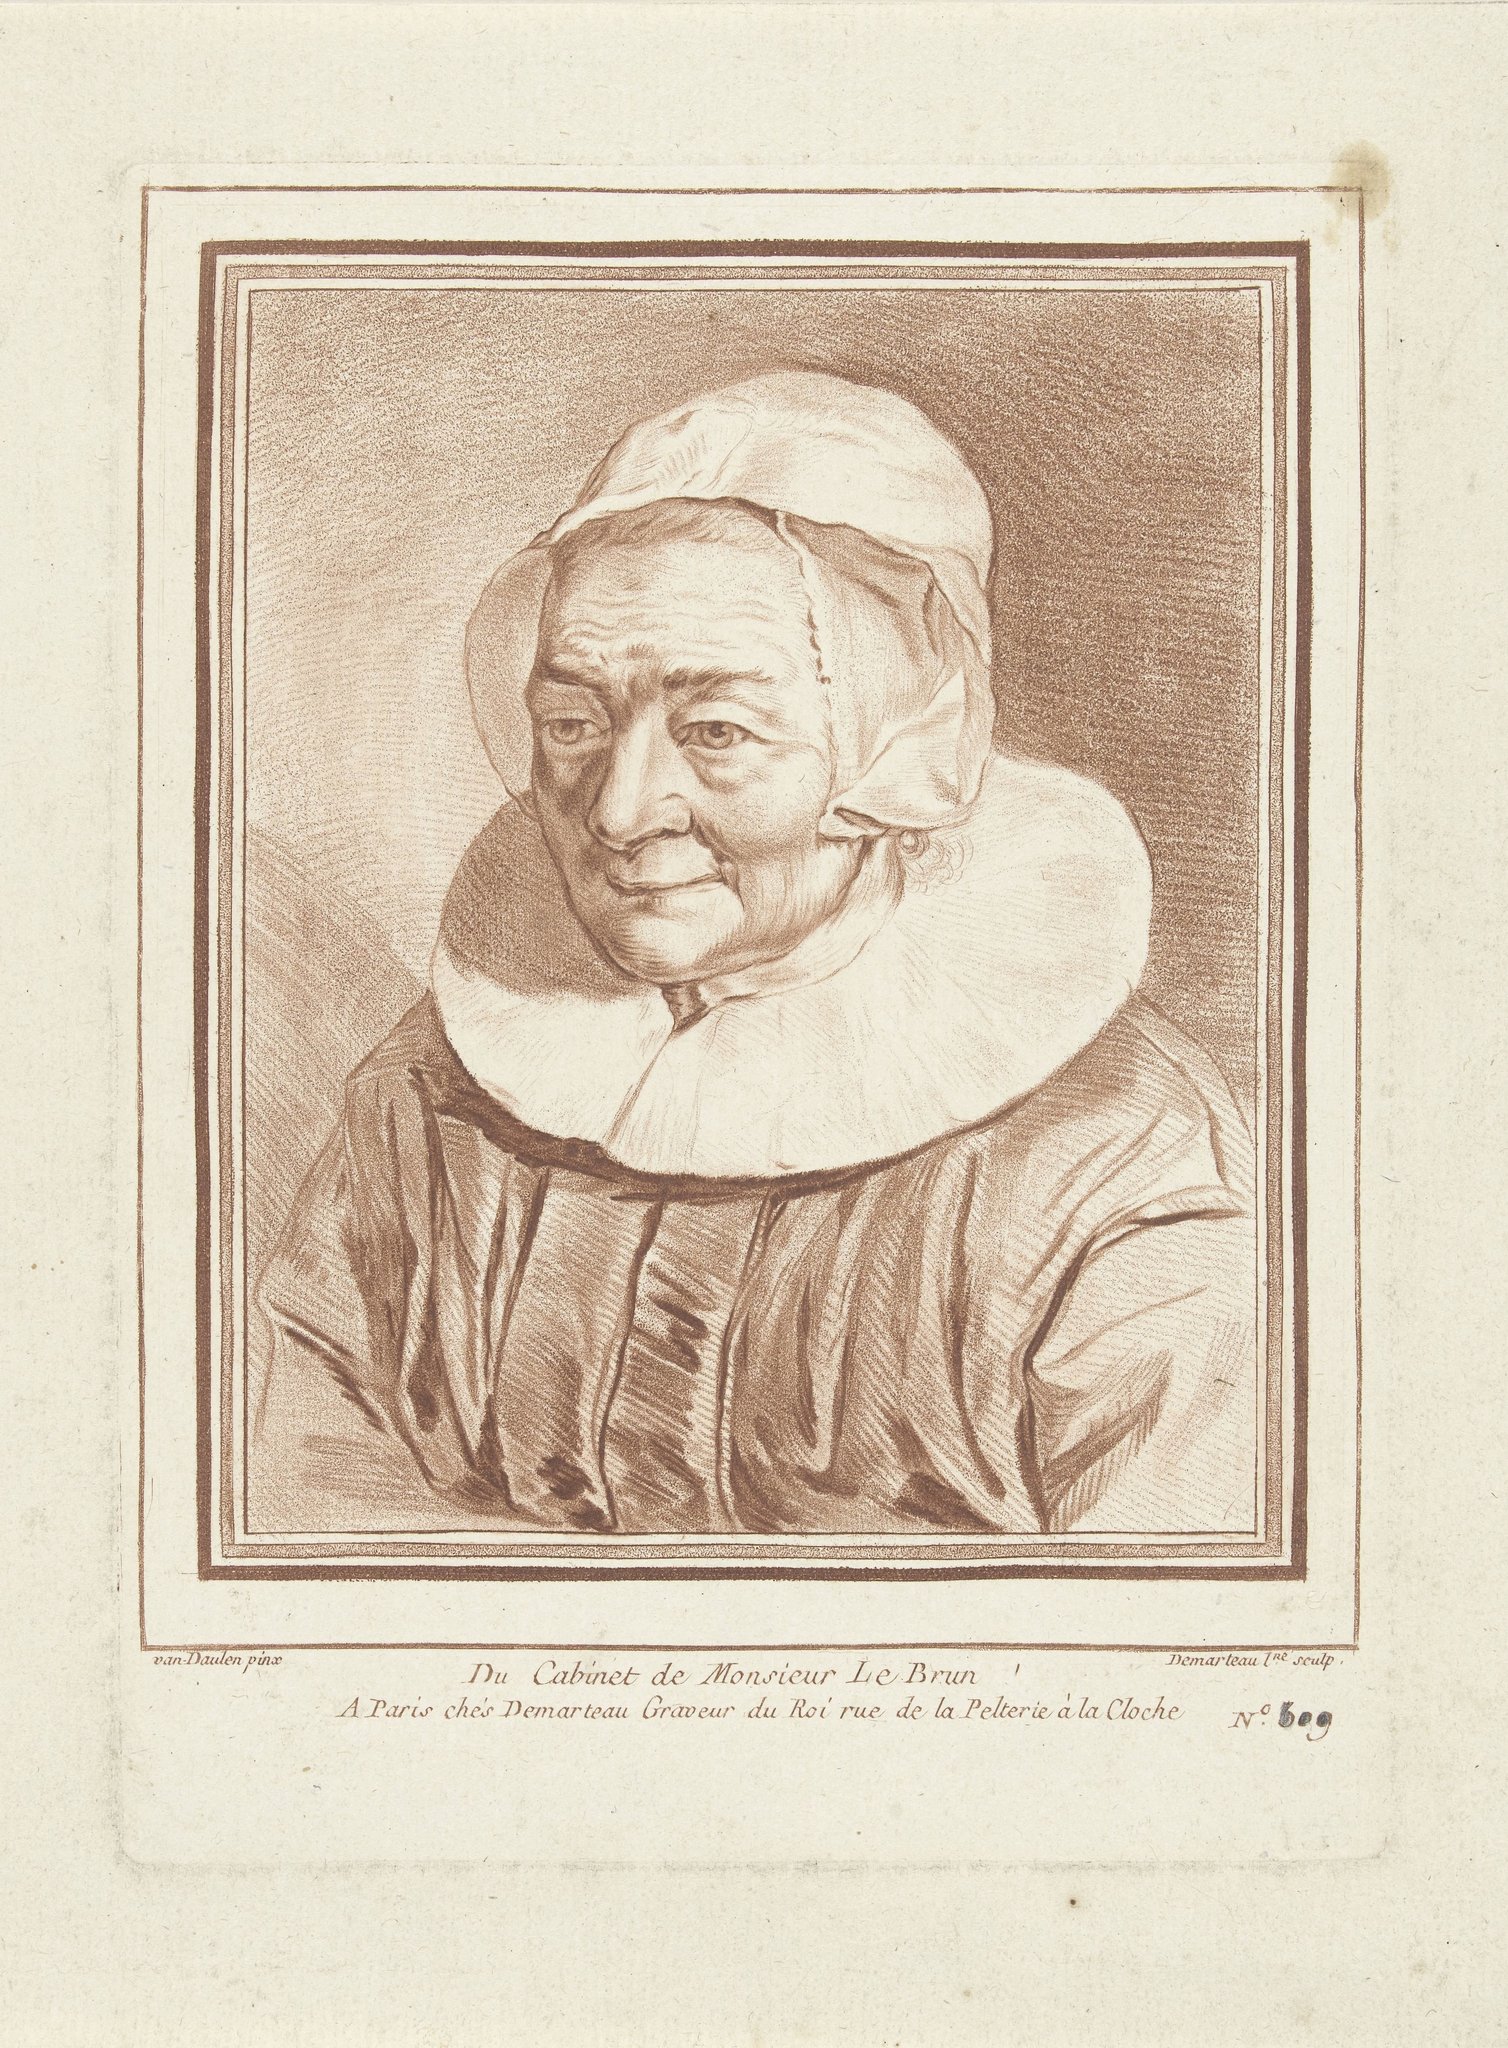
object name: print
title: Buste van oude vrouw met muts en kraag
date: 1732-1776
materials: paper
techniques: printmaking, etching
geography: paris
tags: old woman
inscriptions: collector's mark: Lugt 2228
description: Prent naar schilderij in de verzameling van de heer Le Brun, aldus opschrift.